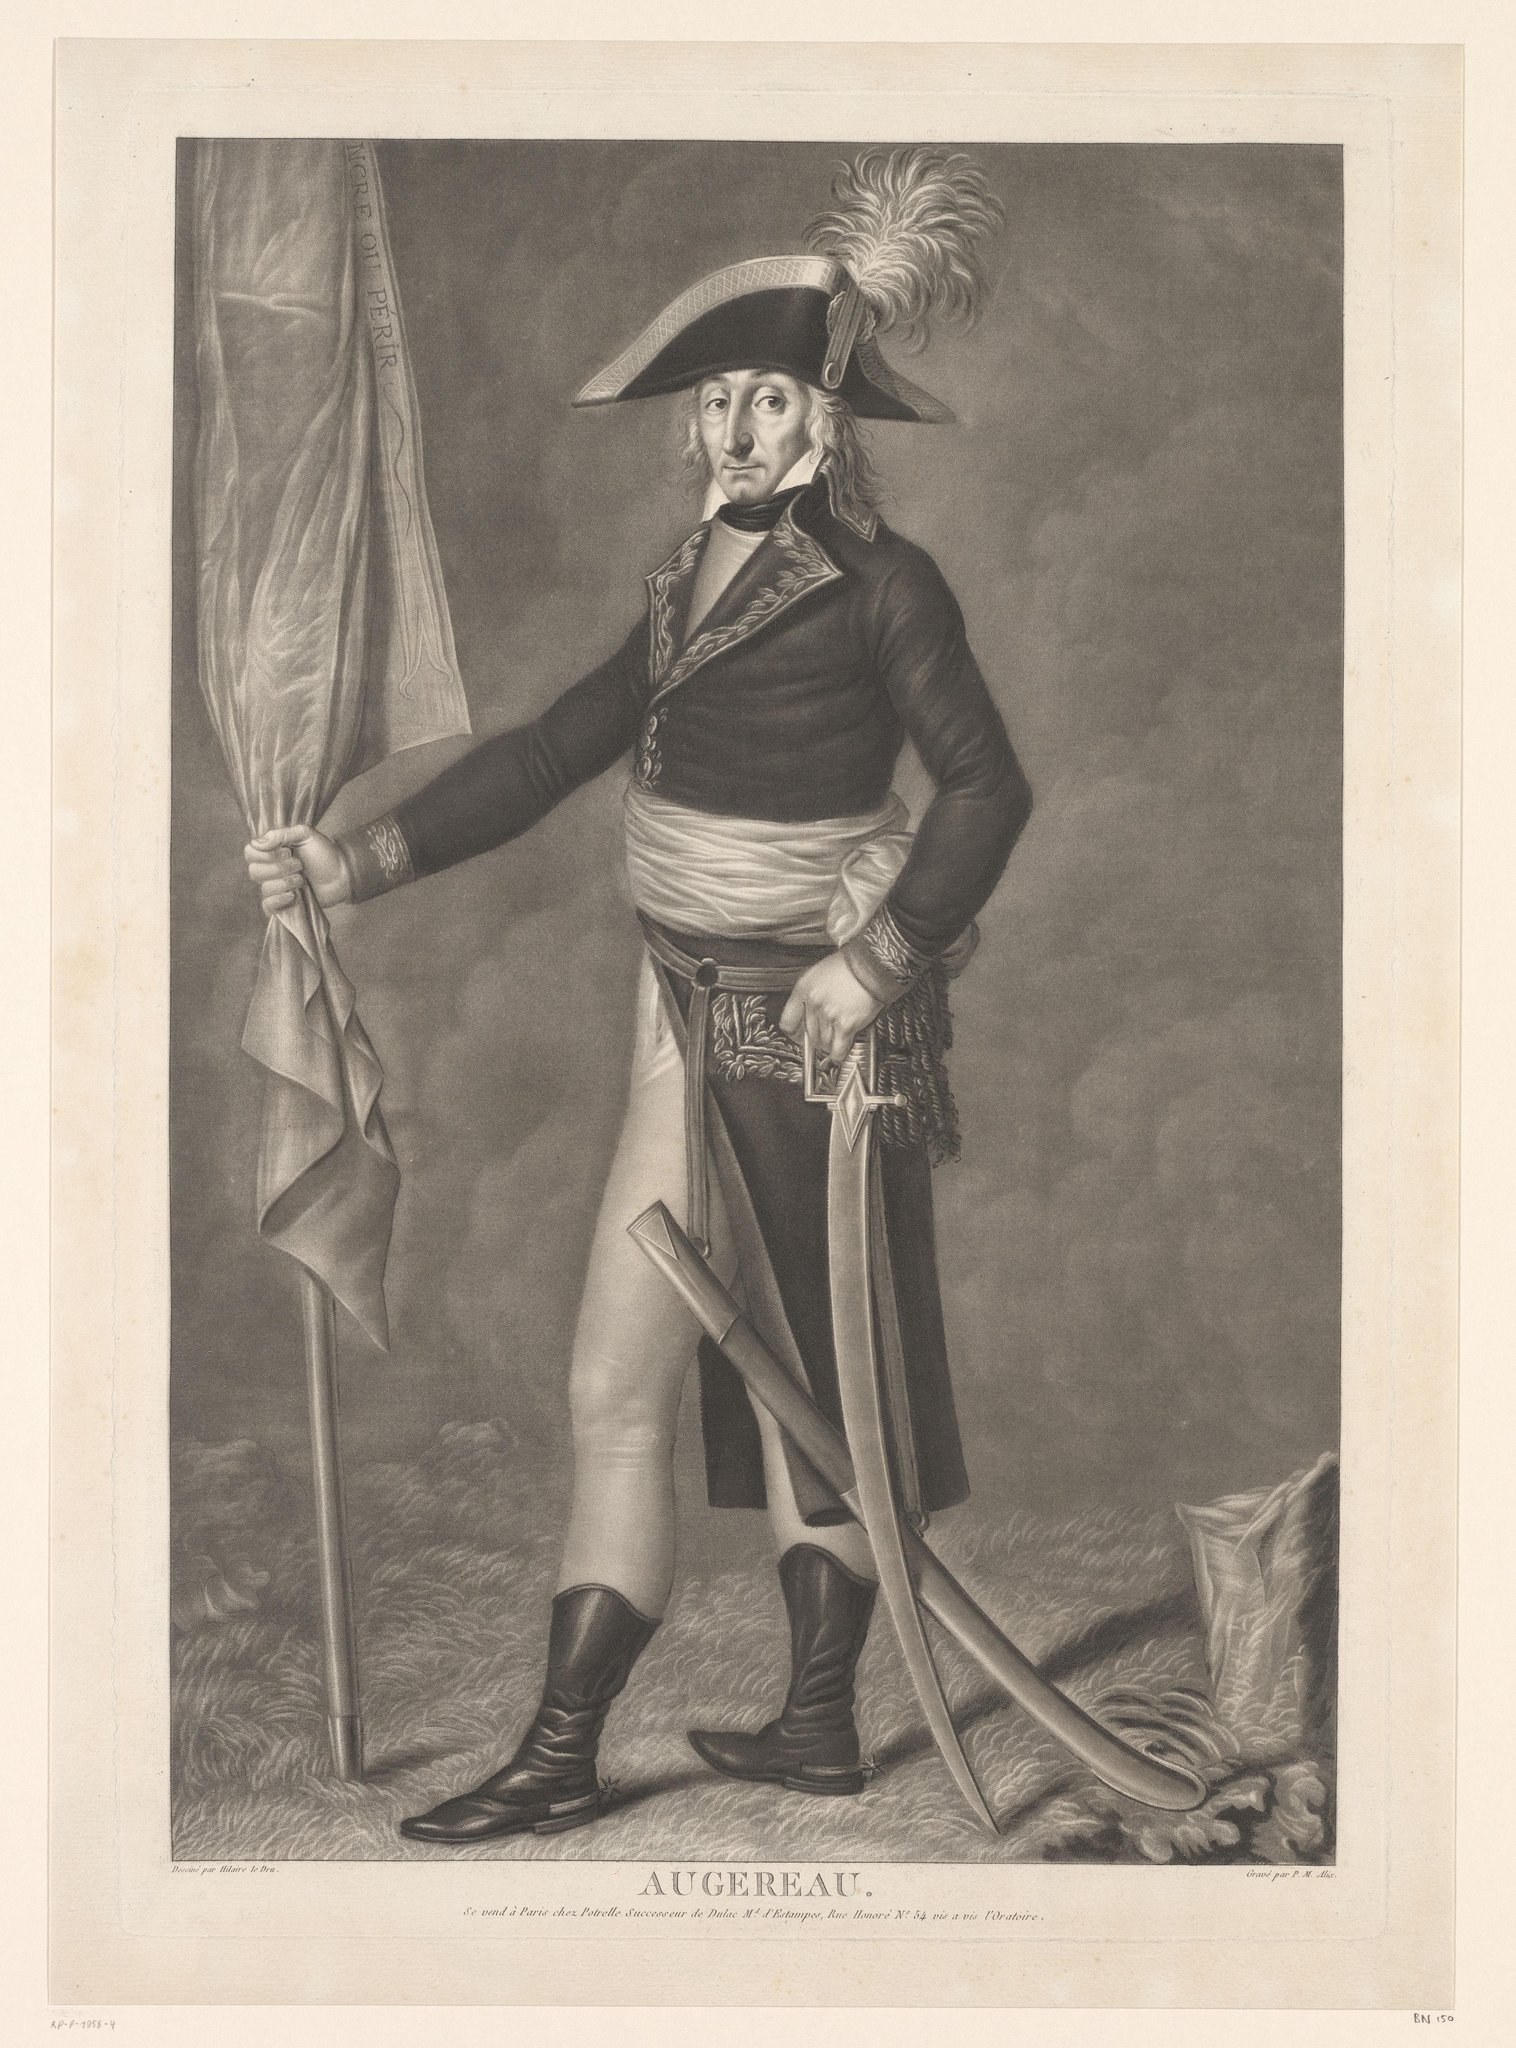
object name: print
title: Augereau.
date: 1796-1817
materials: paper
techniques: aquatint, engraving, roulette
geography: paris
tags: paris, politician, ranks in the army, historical persons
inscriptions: collector's mark: Lugt 2228